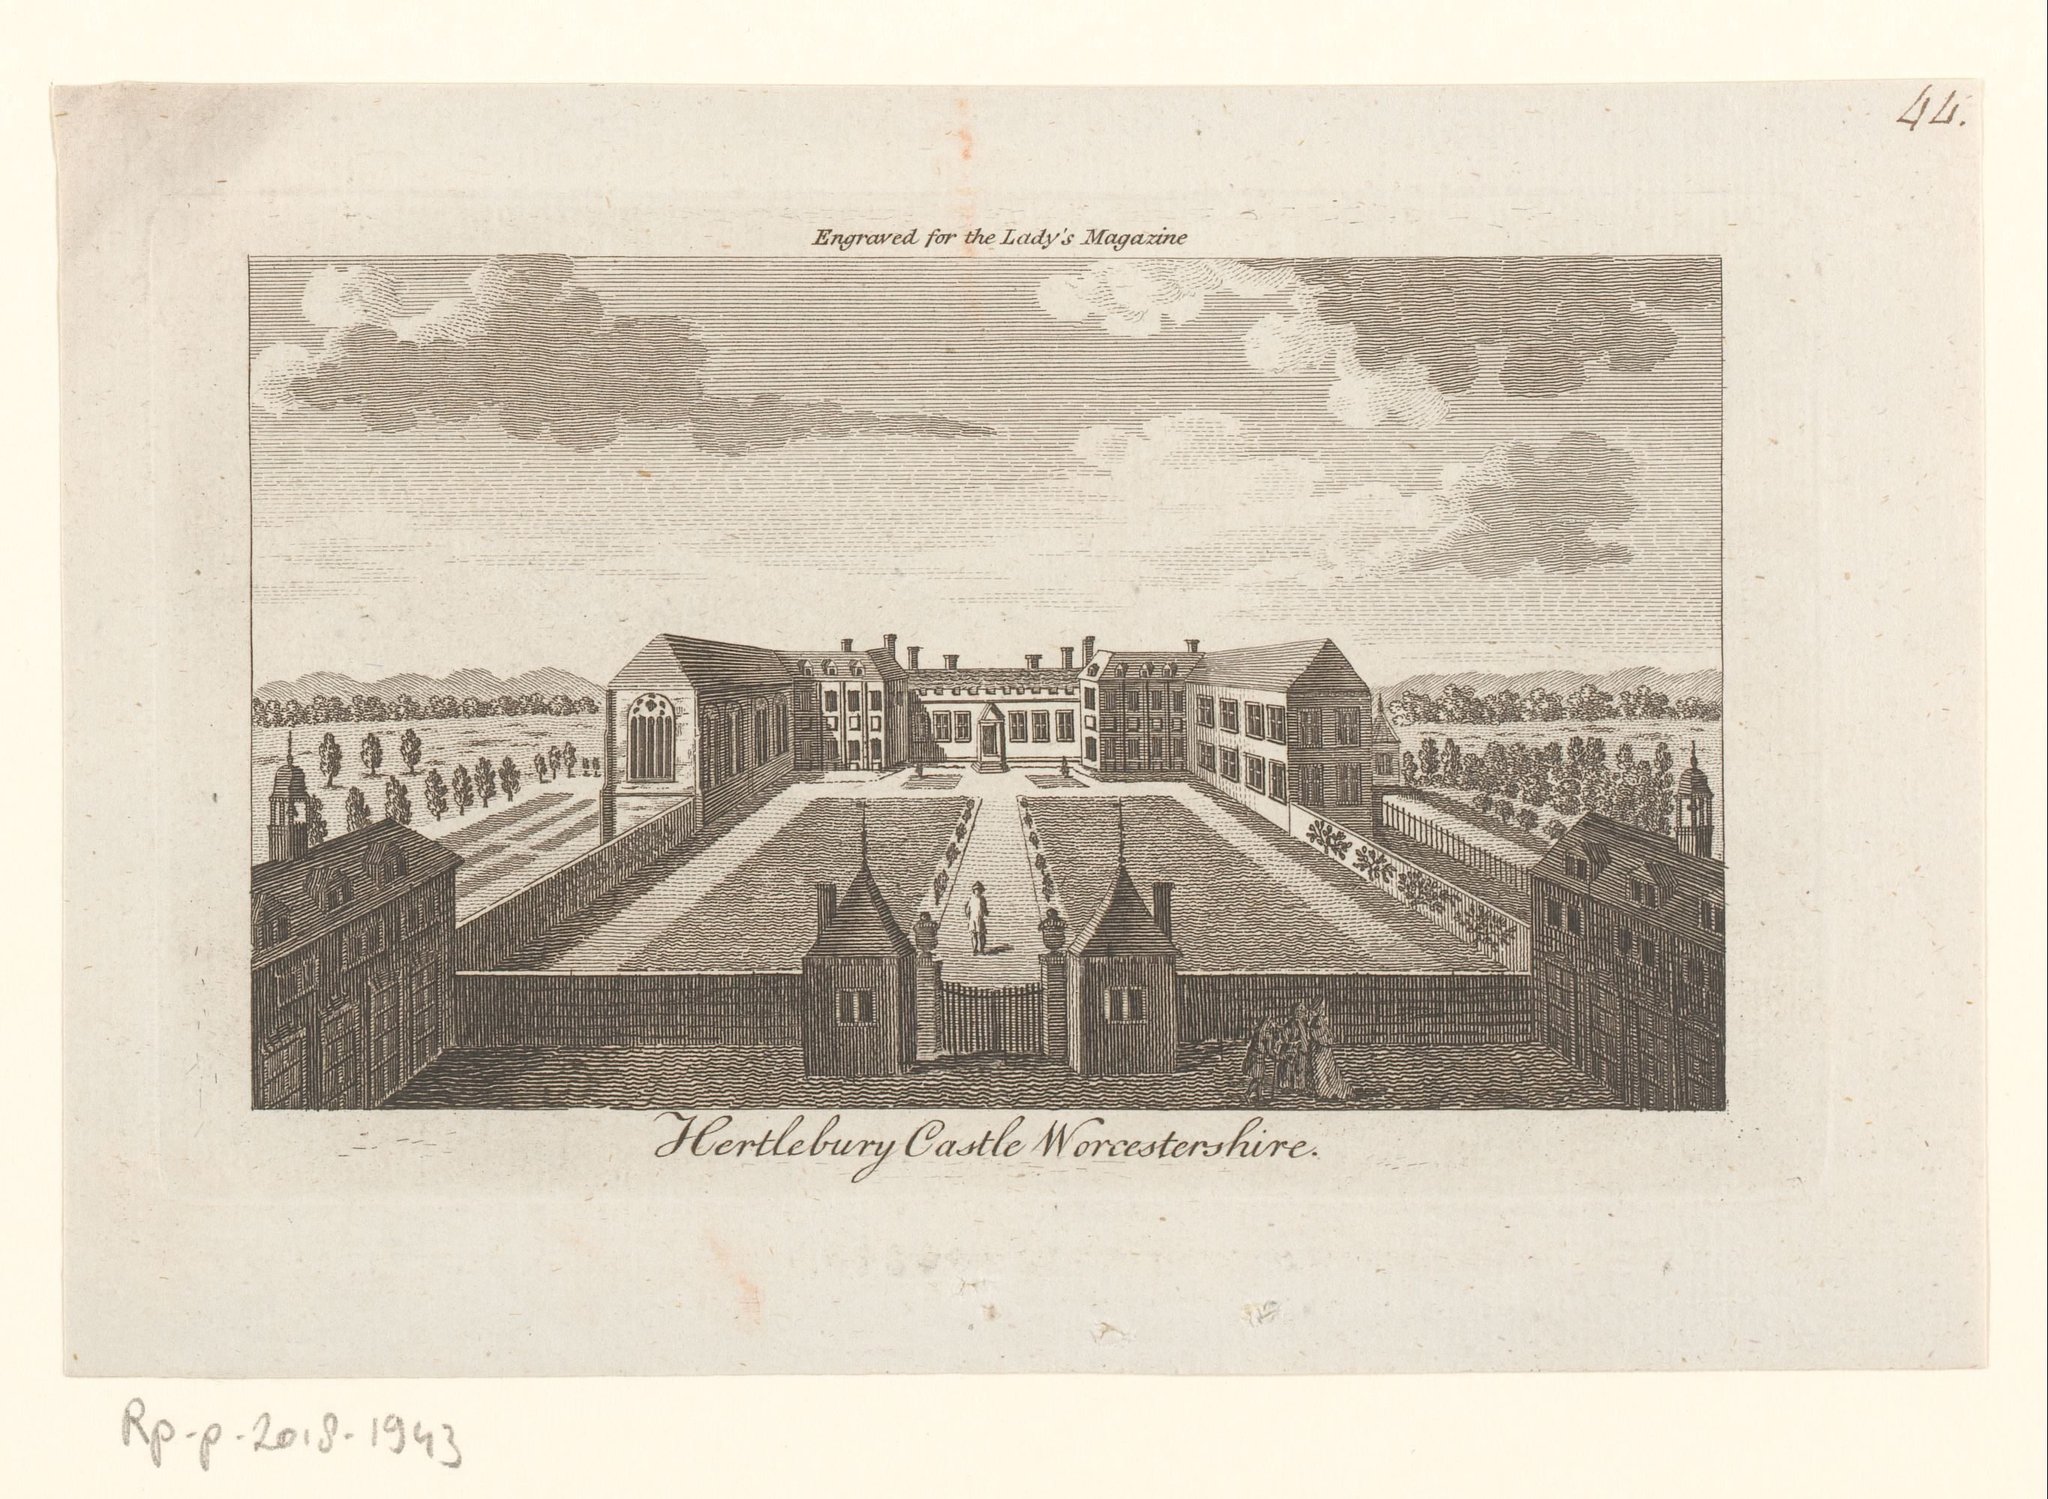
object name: print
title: Hertlebury Castle Worcestershire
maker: Anonymous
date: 1791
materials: paper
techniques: etching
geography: london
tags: castle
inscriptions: collector's mark: Lugt 2228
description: Prent gebruikt in: The Ladies Magazine or entertaining companion for the fair sex (...). Londen: G.G.J & J. Robinson, 1791.